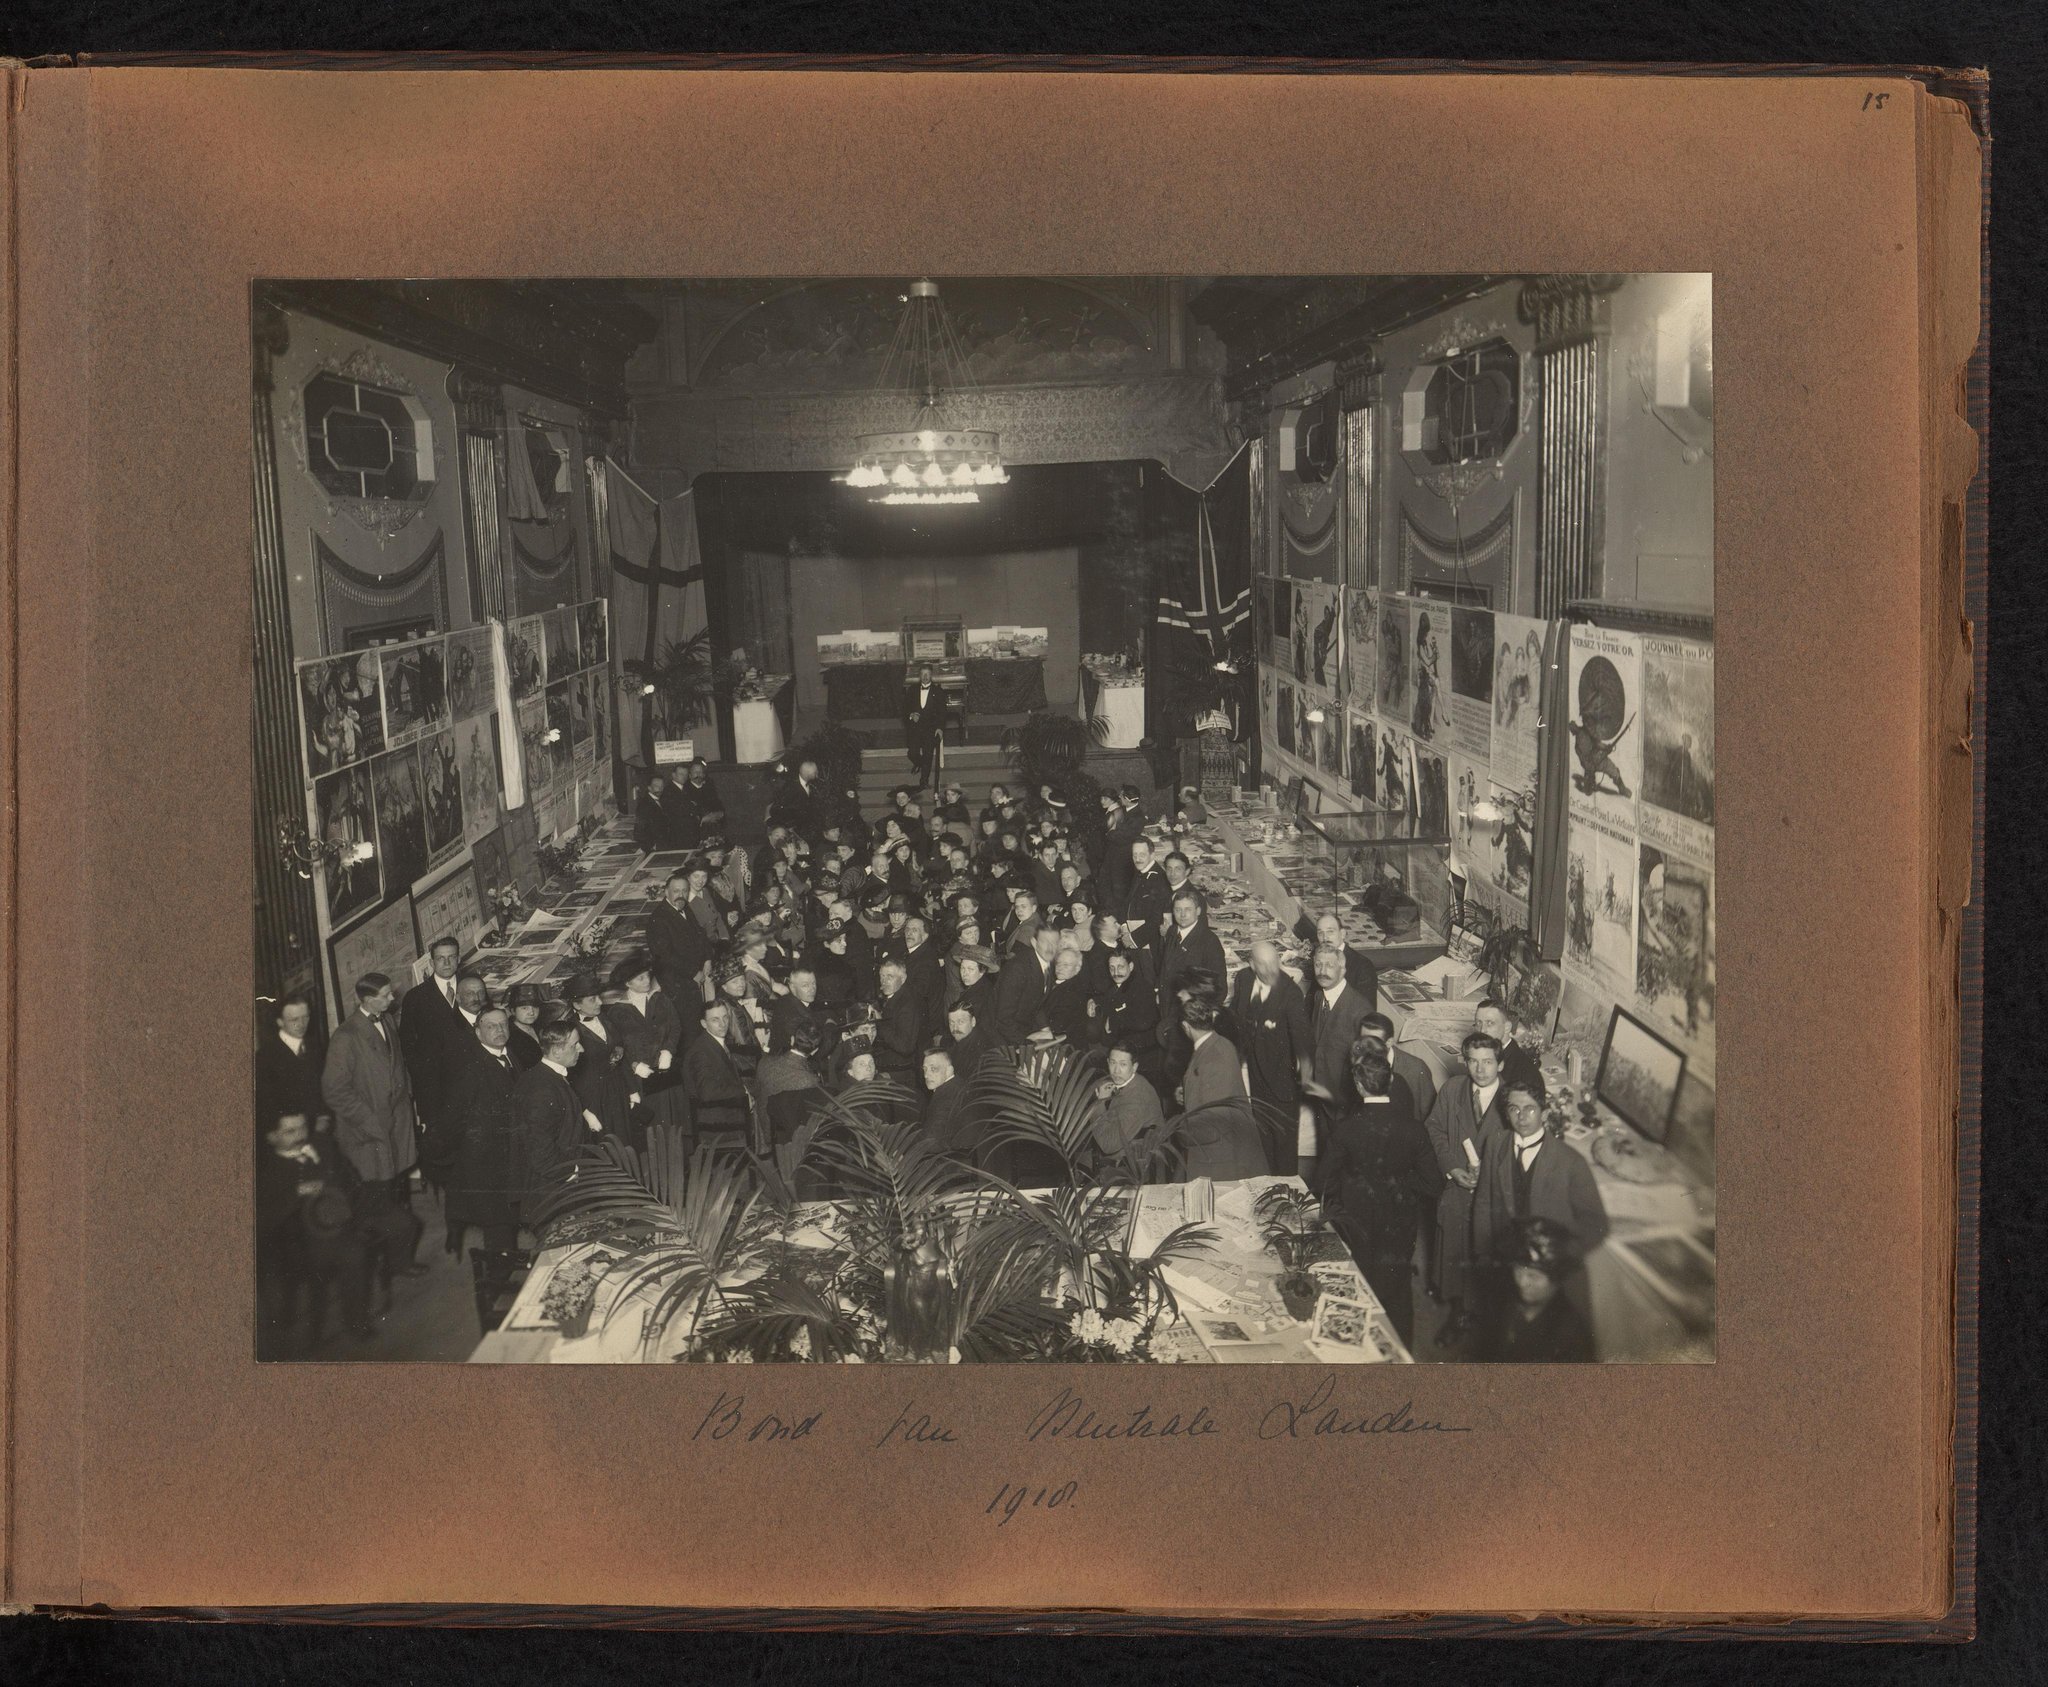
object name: photograph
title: Bladzijde uit het fotoalbum van de familie Diepenbrock met 1 foto van Bond van Neutrale Landen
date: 1918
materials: cardboard, photographic support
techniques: photography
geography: amsterdam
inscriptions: inscription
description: Bruin albumblad 15 van familiealbum van Alphons Diepenbrock.